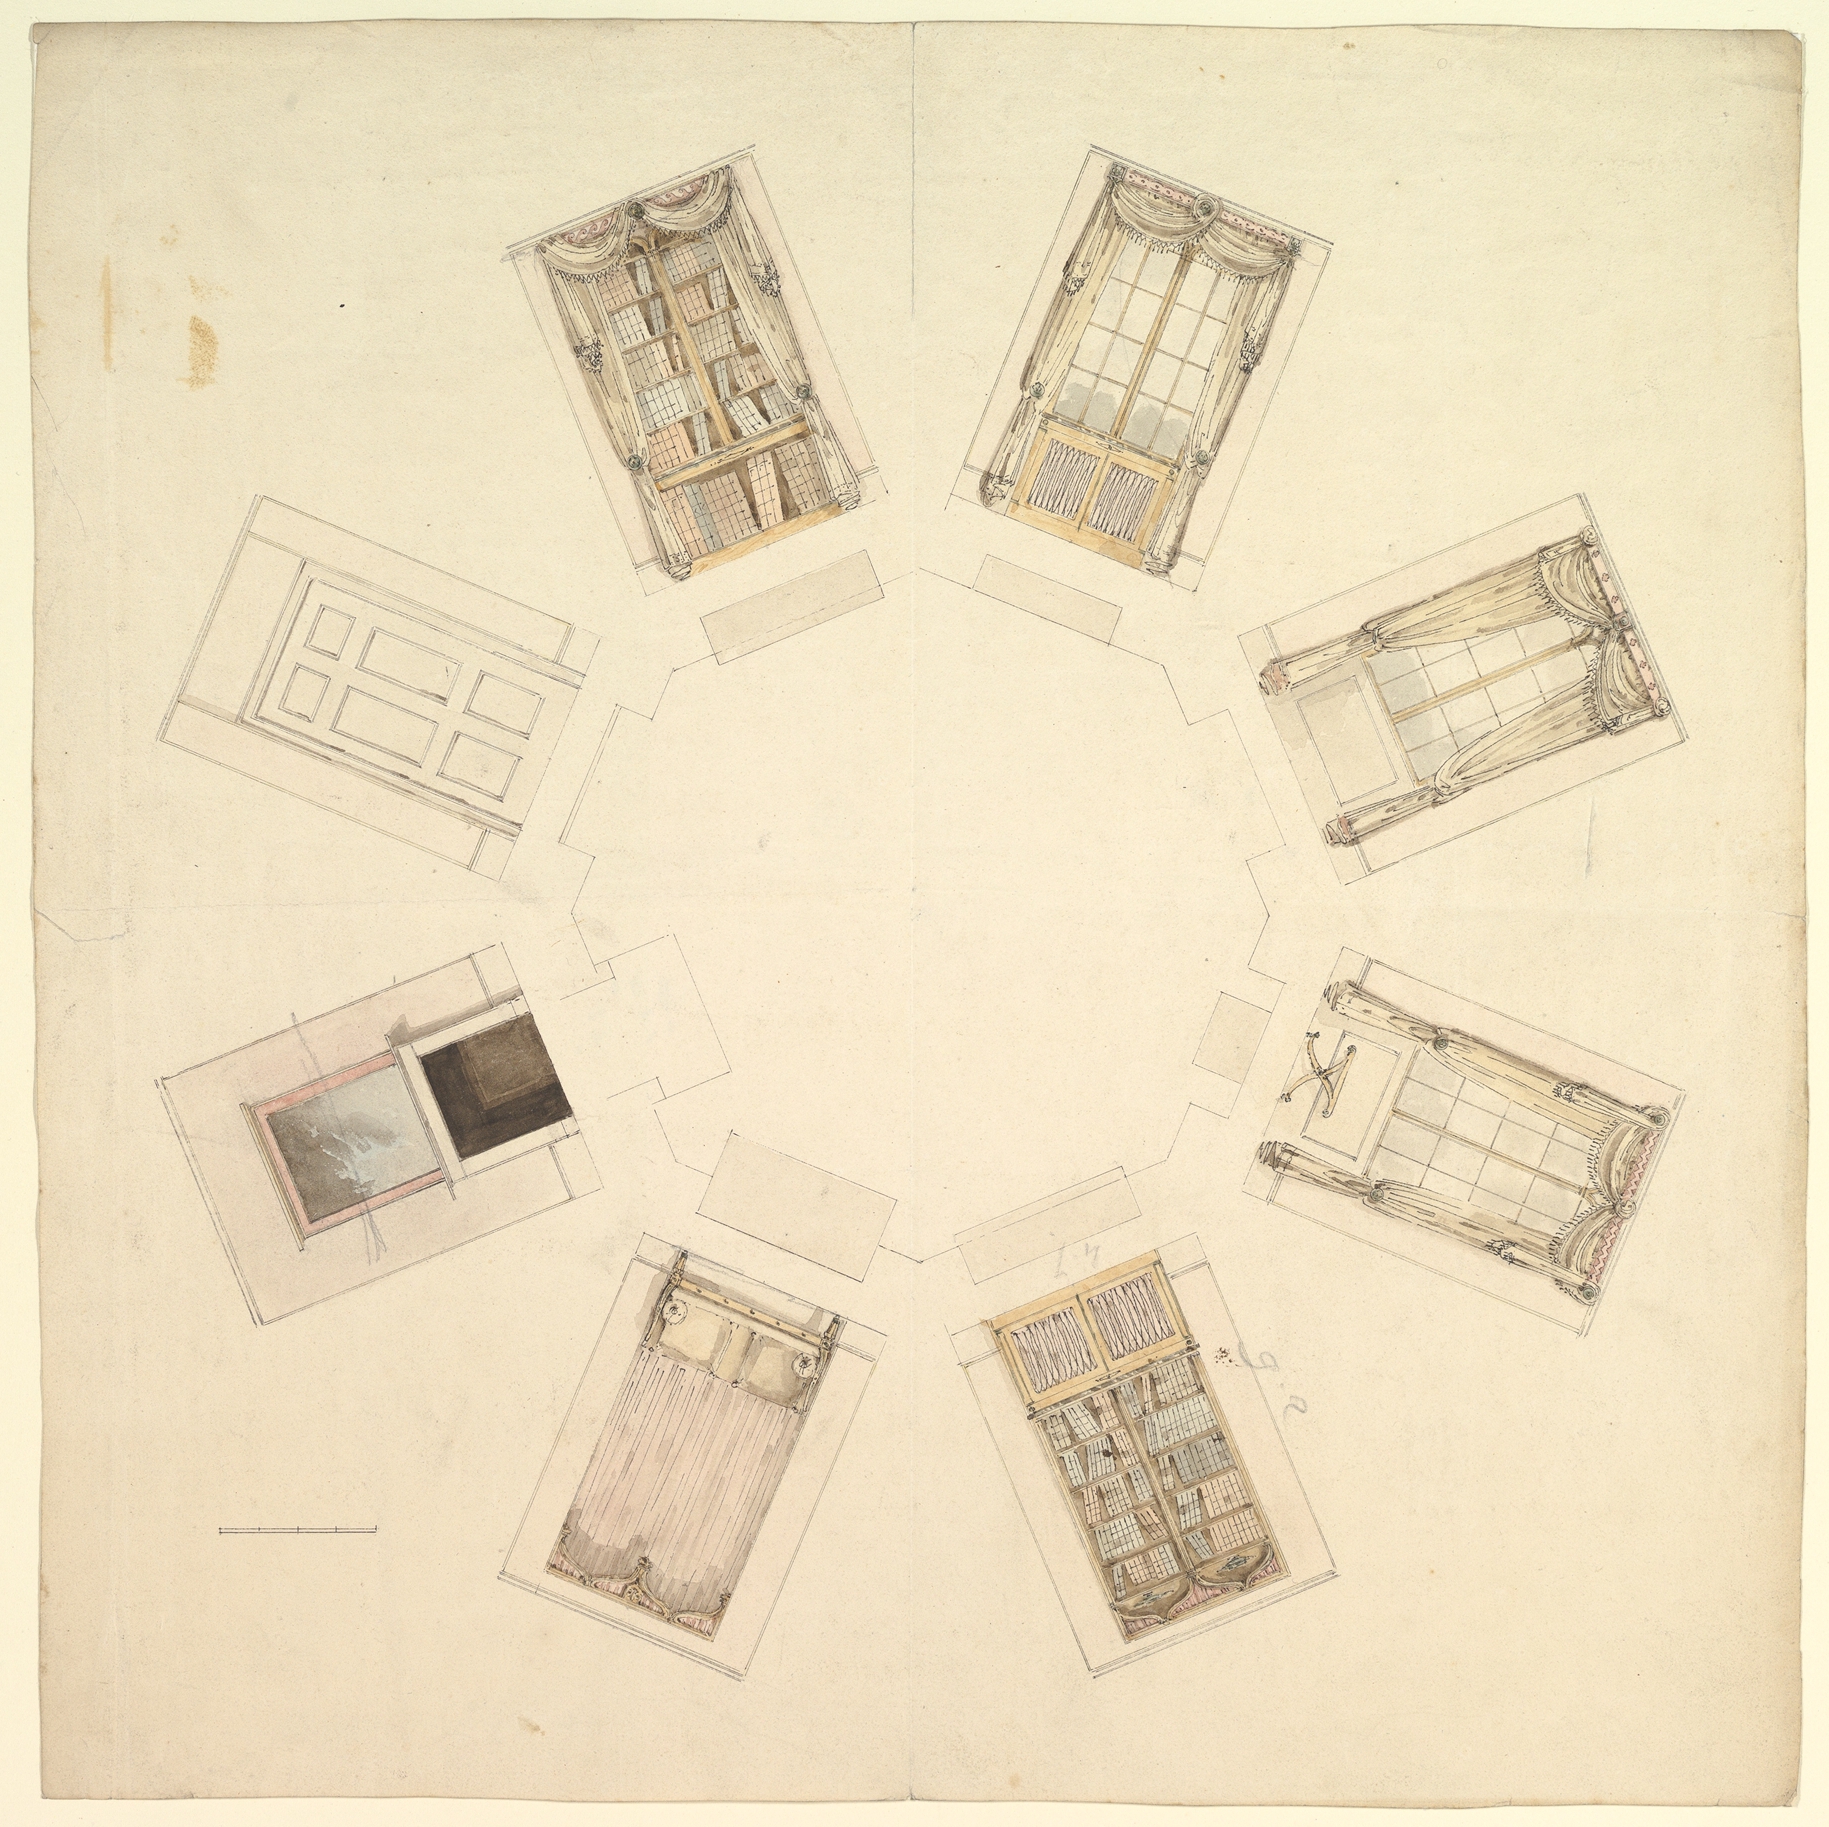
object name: drawing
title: Octagonal Room with Sectional Views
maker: anonymous, british, 19th century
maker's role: artist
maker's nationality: british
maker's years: 1800-1900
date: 1801-1900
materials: ink, watercolor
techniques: pen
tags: architecture